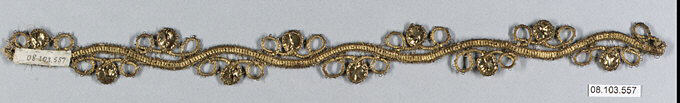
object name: galloon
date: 1701-1800